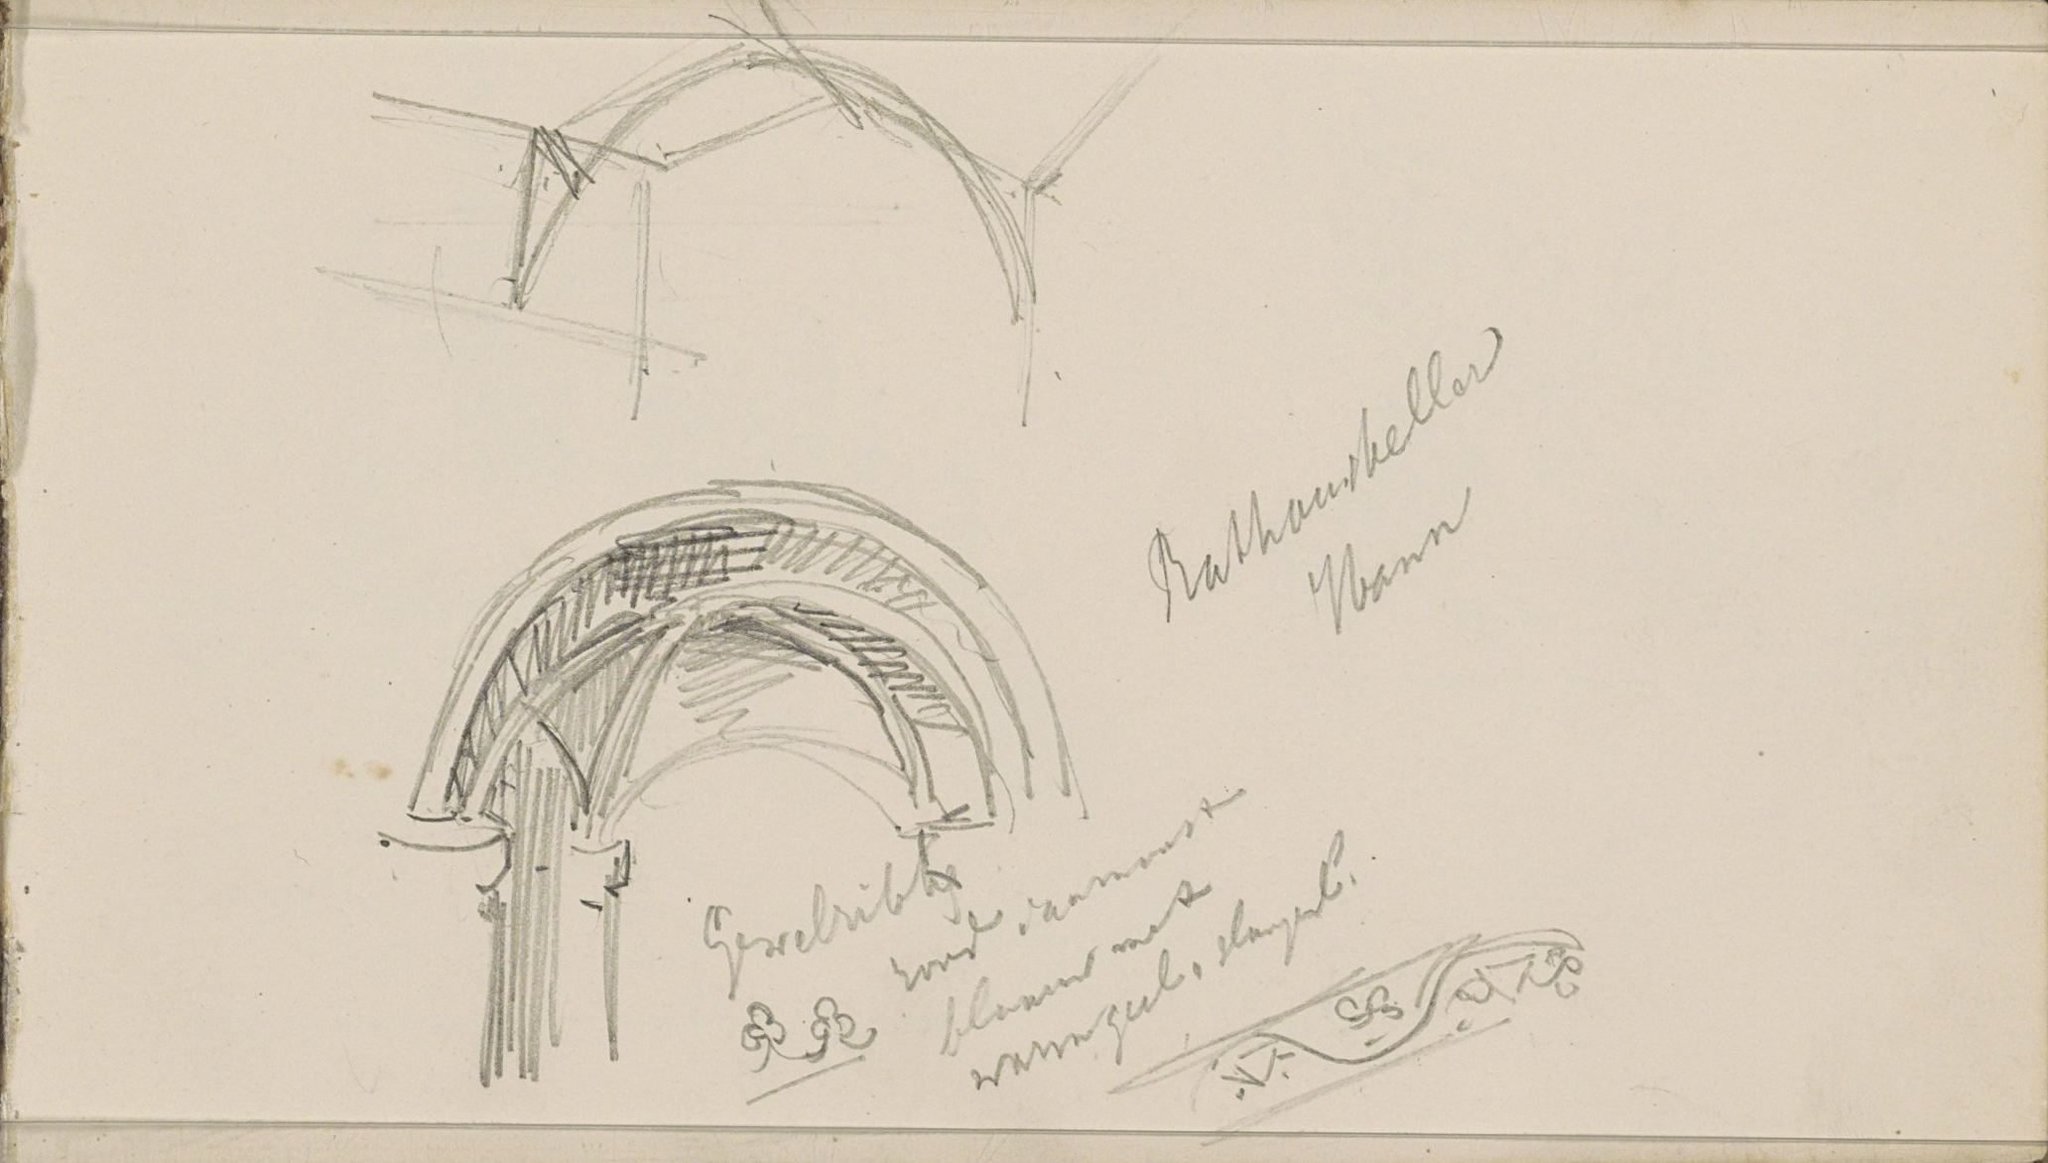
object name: sketchbook leaf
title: Gewelfribben in de kelder van het stadhuis te Hannover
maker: isaac gosschalk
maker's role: draughtsman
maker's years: 1838-1907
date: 1866-1868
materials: paper, pencil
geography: hannover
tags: vault ~ architecture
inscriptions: annotation: ‘Rathauskeller/ Hann/ Gewelfribben’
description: Blad 7 recto uit een schetsboek met 67 bladen.